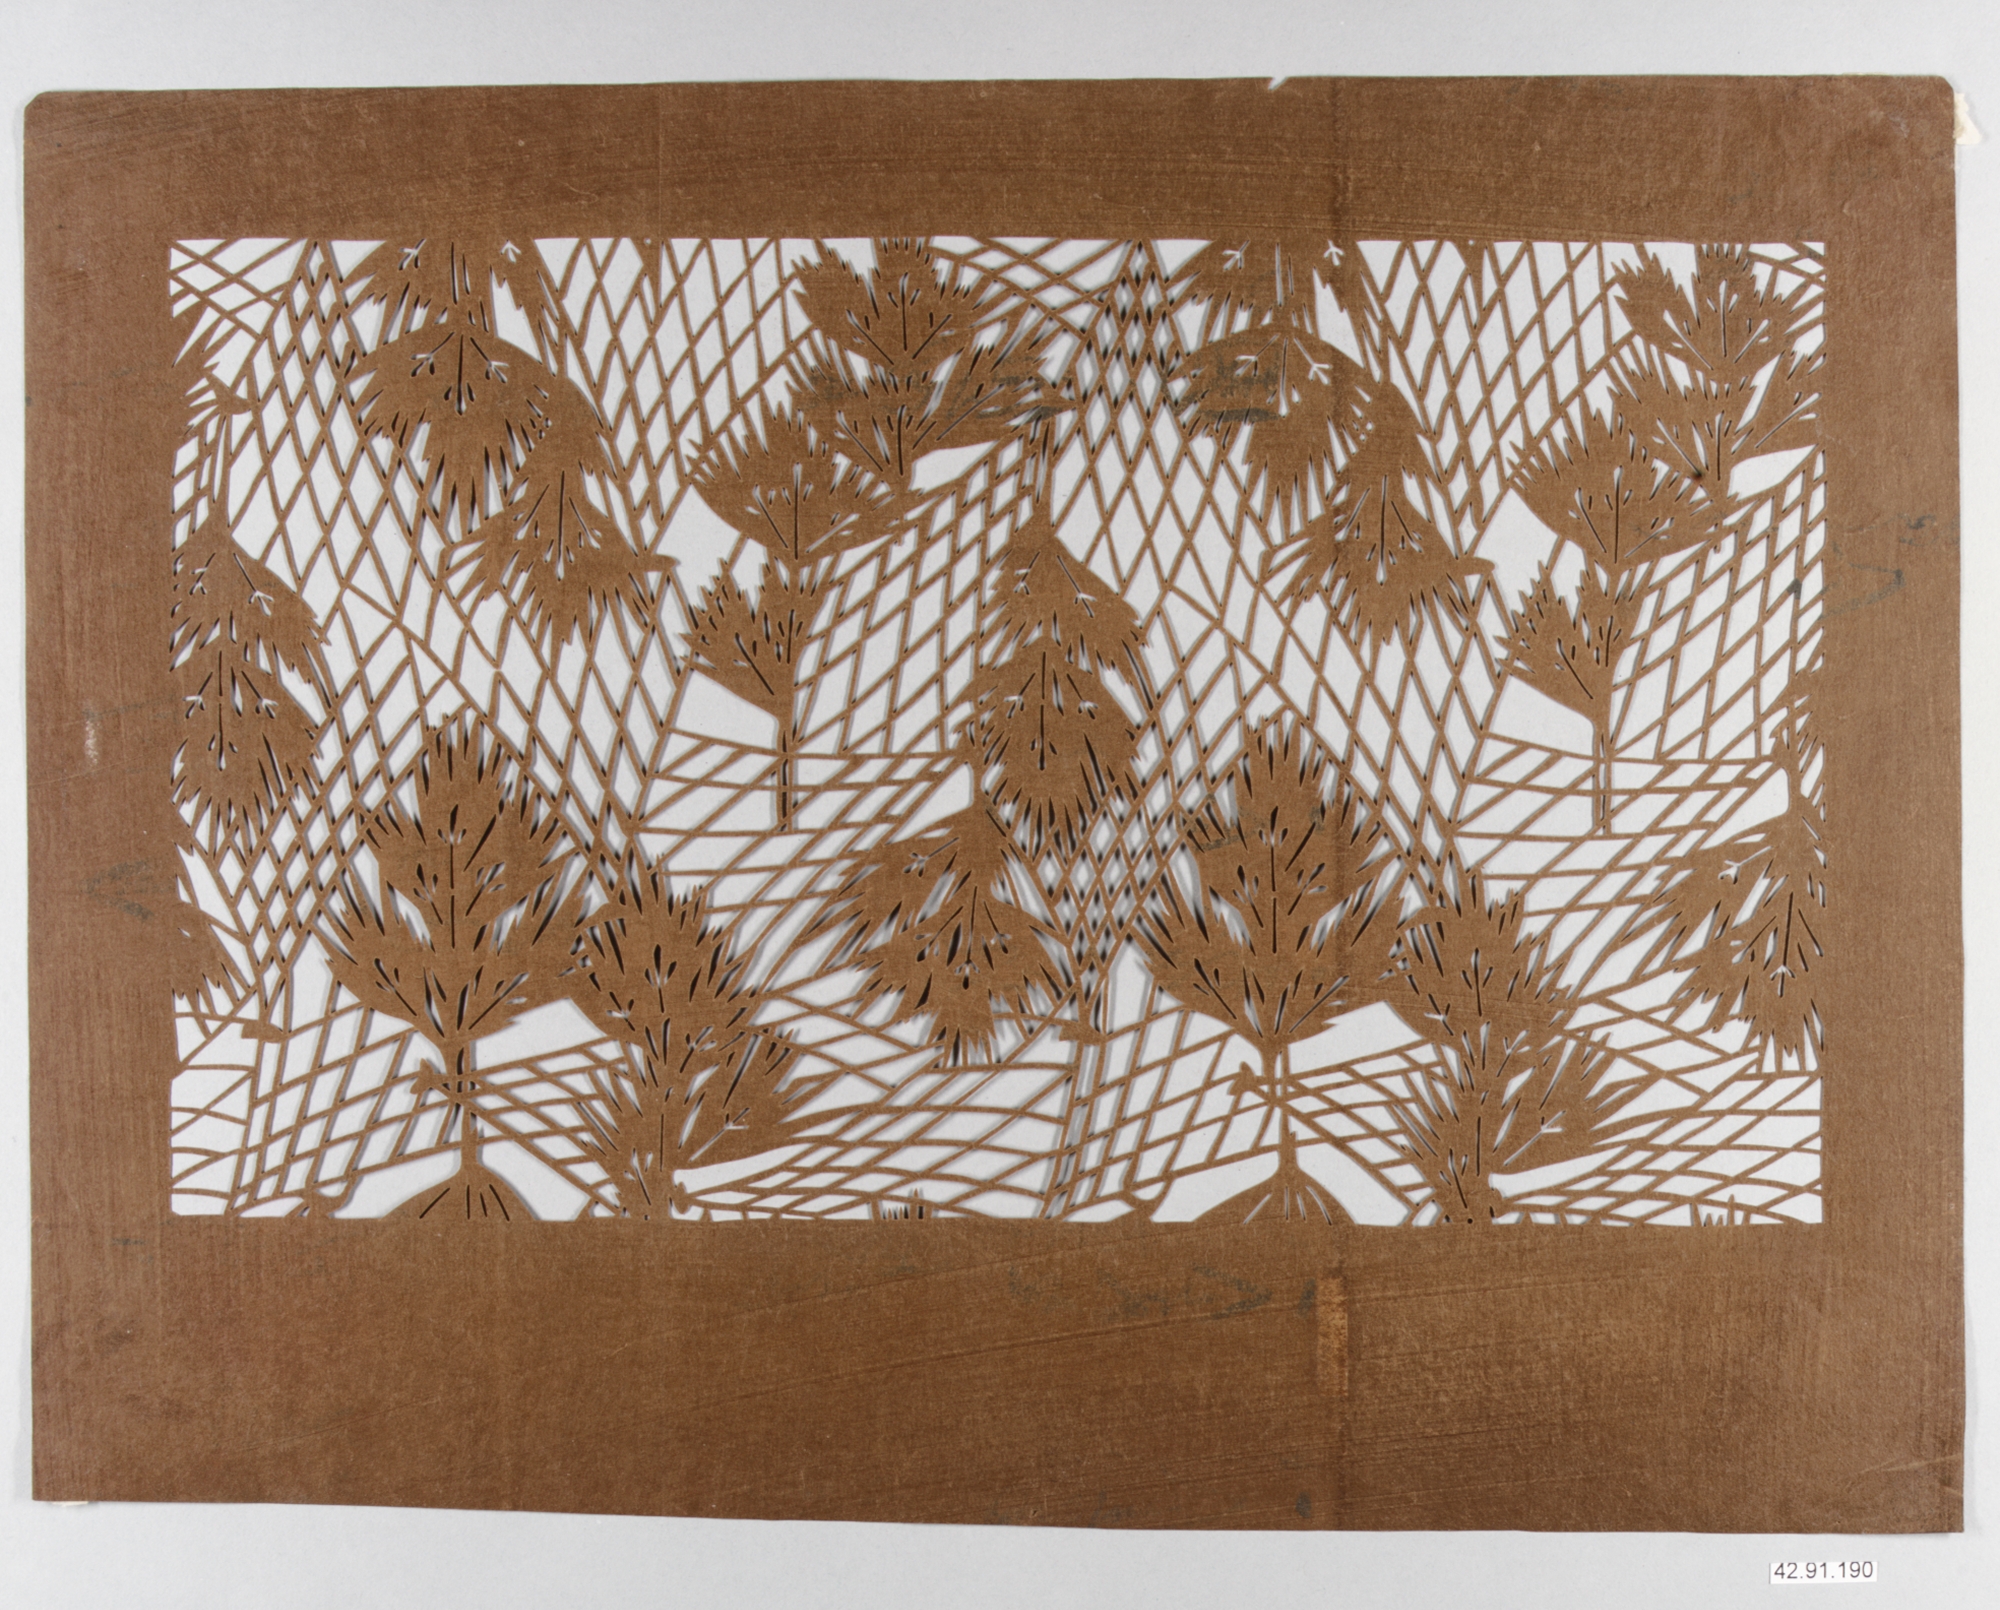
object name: stencil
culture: japanese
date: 1801-1900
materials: paper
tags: leaves